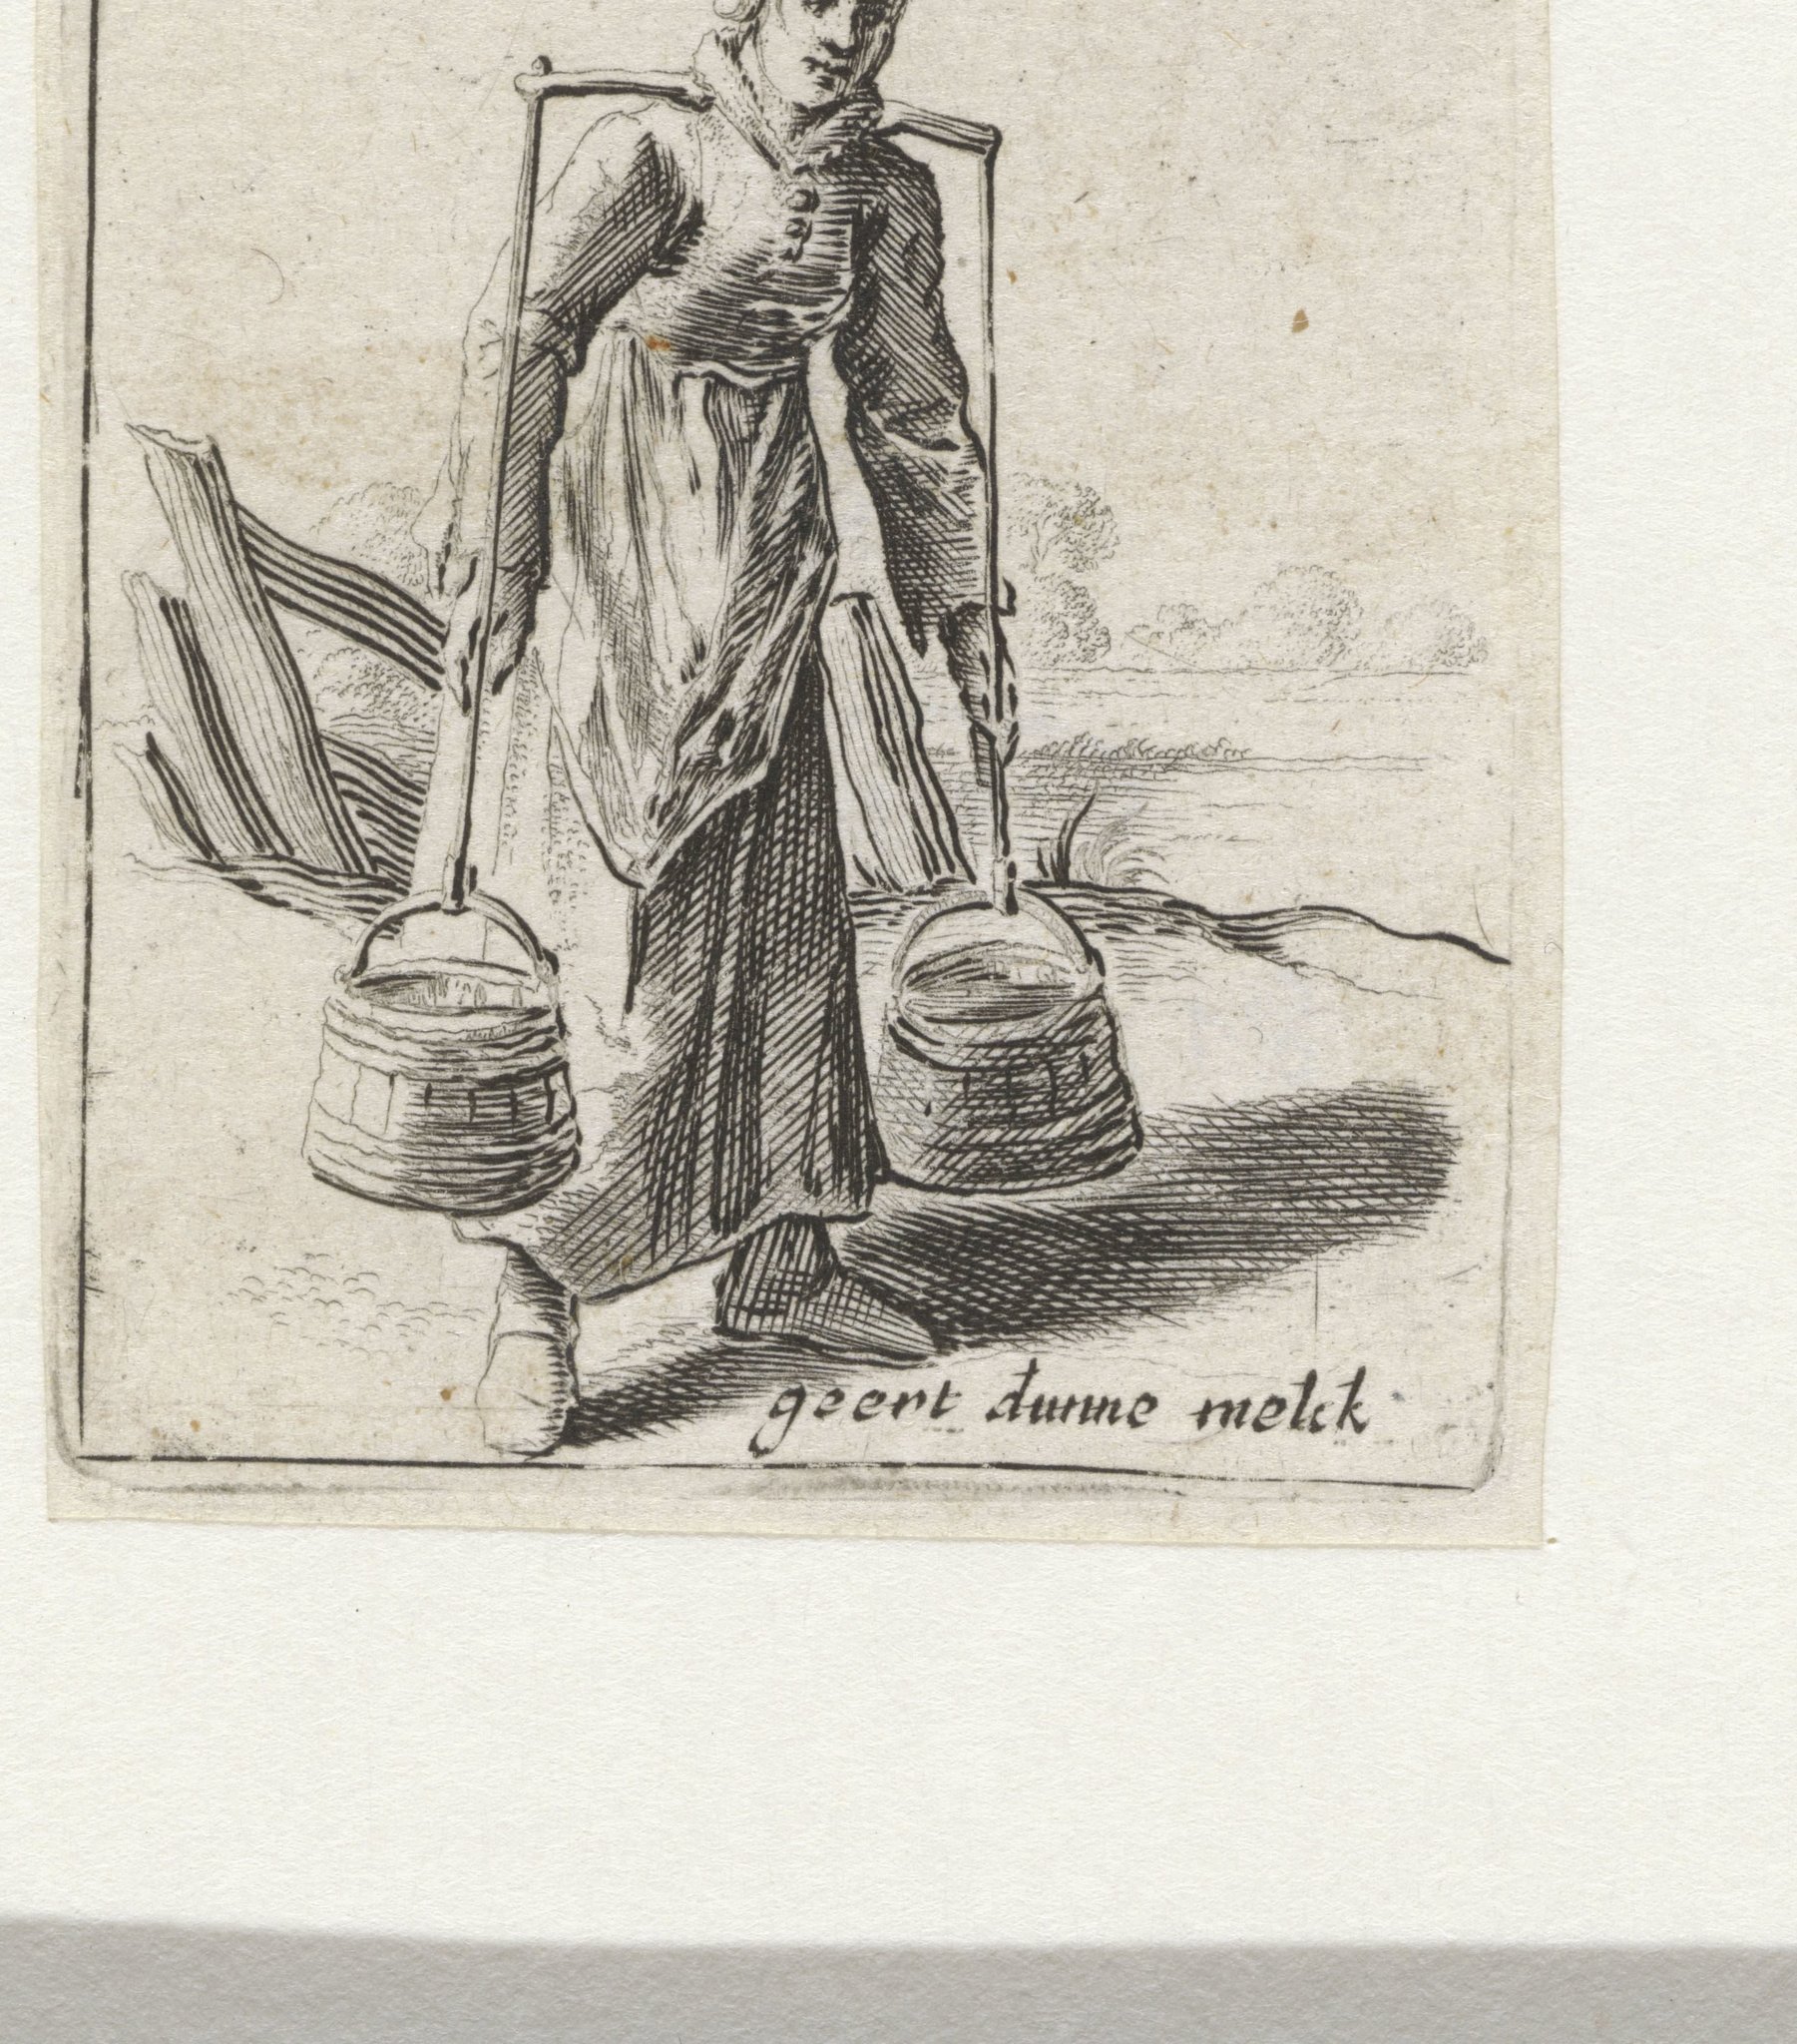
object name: print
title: Vrouw met een juk met emmers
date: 1638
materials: paper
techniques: engraving, etching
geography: netherlands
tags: carrying something with yoke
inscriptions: collector's mark: Lugt 2228, collector's mark: Lugt 2760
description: Een vrouw met een juk met twee emmers met melk staat voor een hek. De prent maakt deel uit van een serie van 32 prenten met genretaferelen.